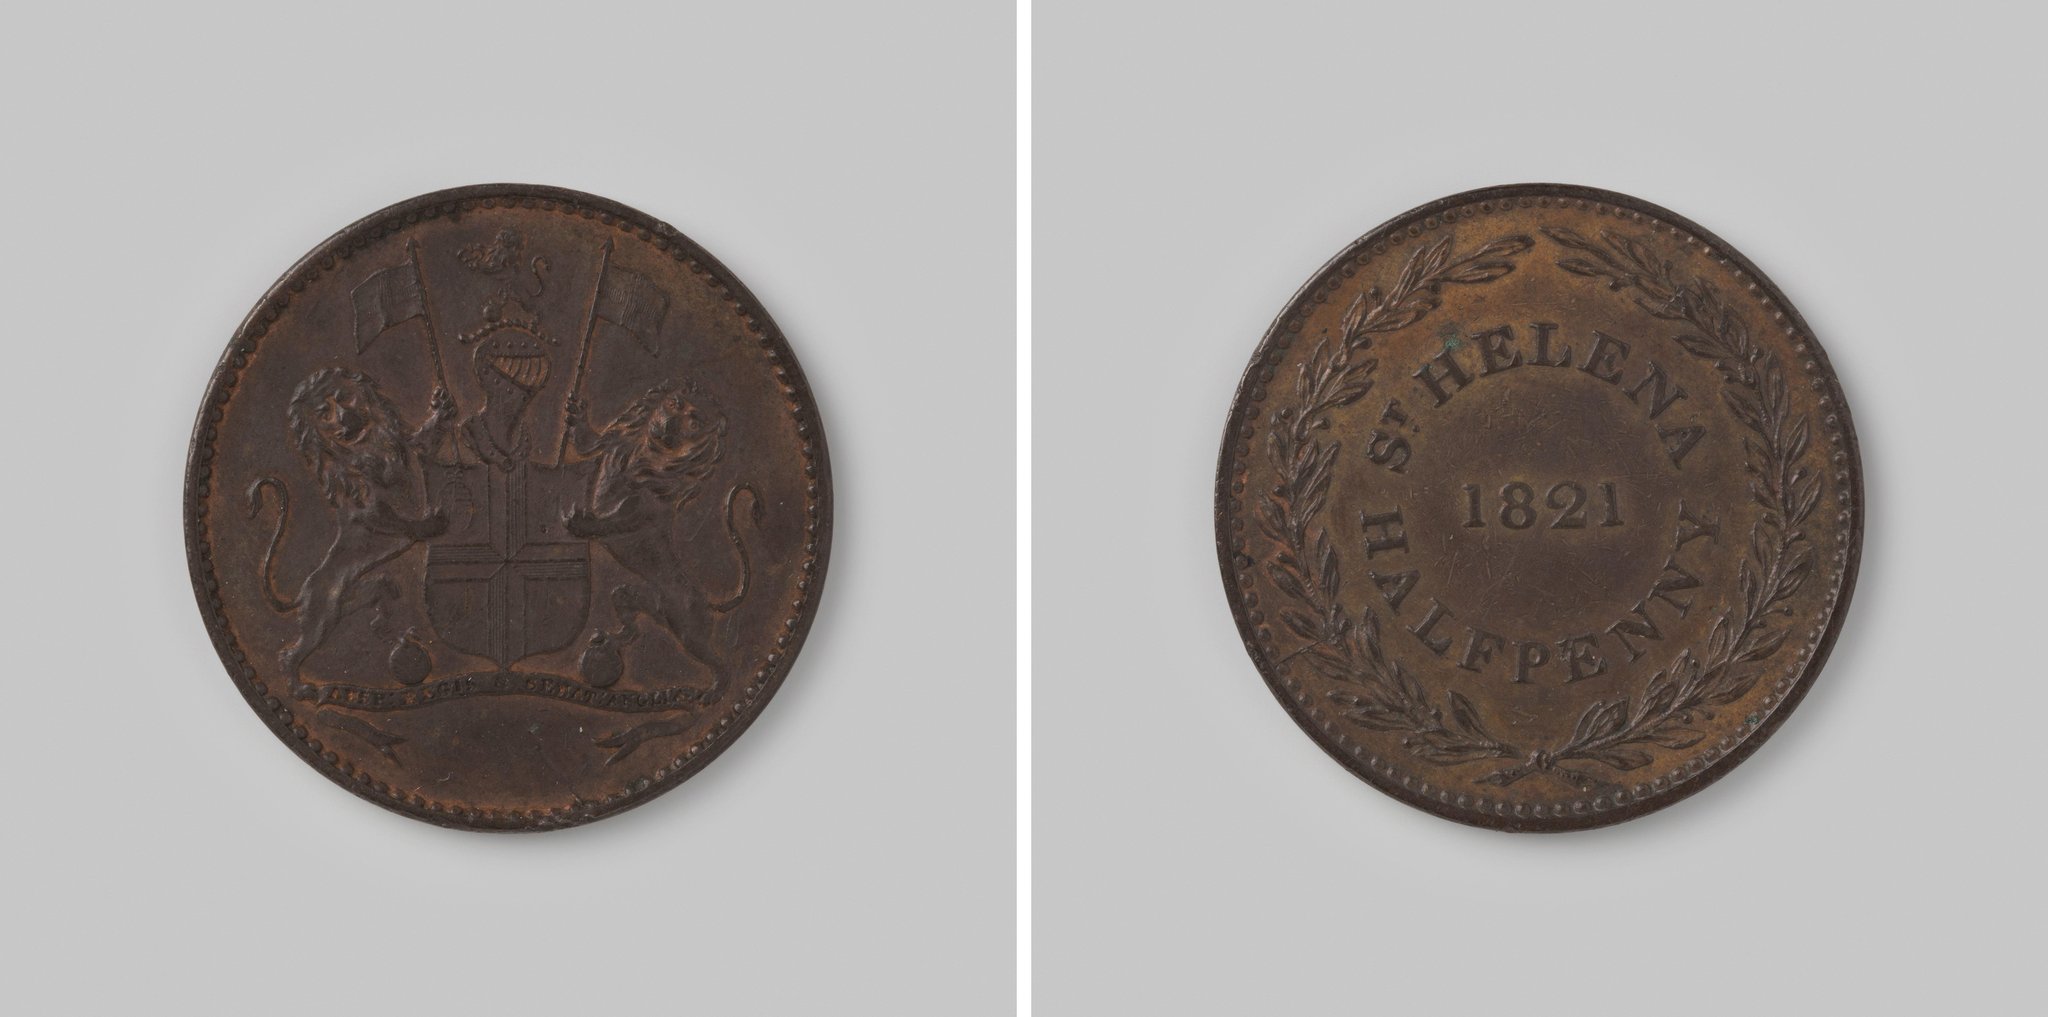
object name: coin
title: Halfpenny voor St. Helena van de Engelse Oostindische Compagnie (EIC), 1821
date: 1821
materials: copper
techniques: striking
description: Koperen munt. Voorzijde: door twee op banderol, waarin opschrift, staande leeuwen met pijl, waaraan vlag, in de klauw, gehouden wapenschild van de EIC, waarboven helmteken. Keerzijde: tussen twee samengebonden takken jaartal. Daarboven lands-aanduiding en daaronder waarde-aanduiding: halfpenny. Gladde rand.